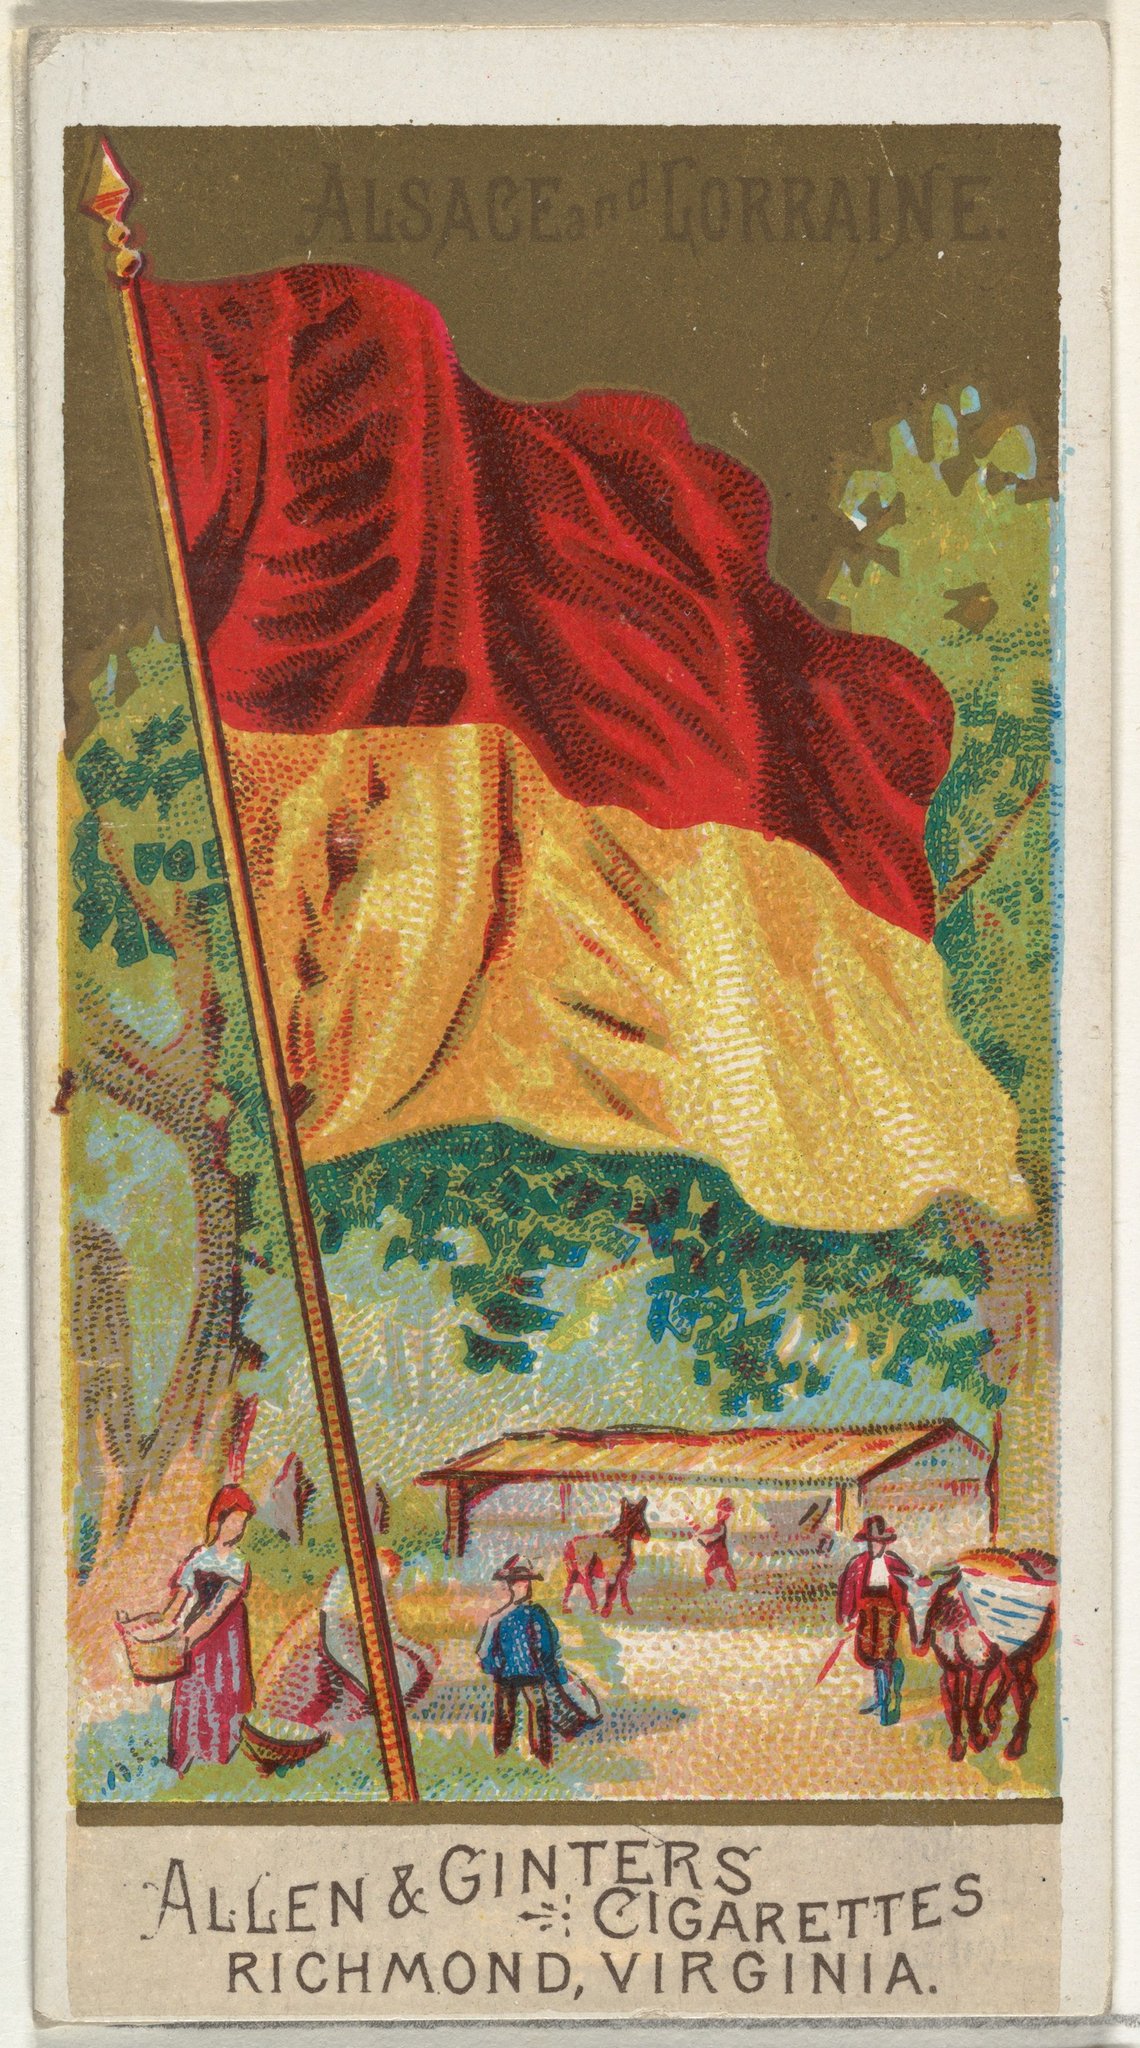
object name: print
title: Alsace and Lorraine, from Flags of All Nations, Series 2 (N10) for Allen & Ginter Cigarettes Brands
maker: allen & ginter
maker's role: publisher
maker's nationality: american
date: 1890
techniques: color lithograph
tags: flags